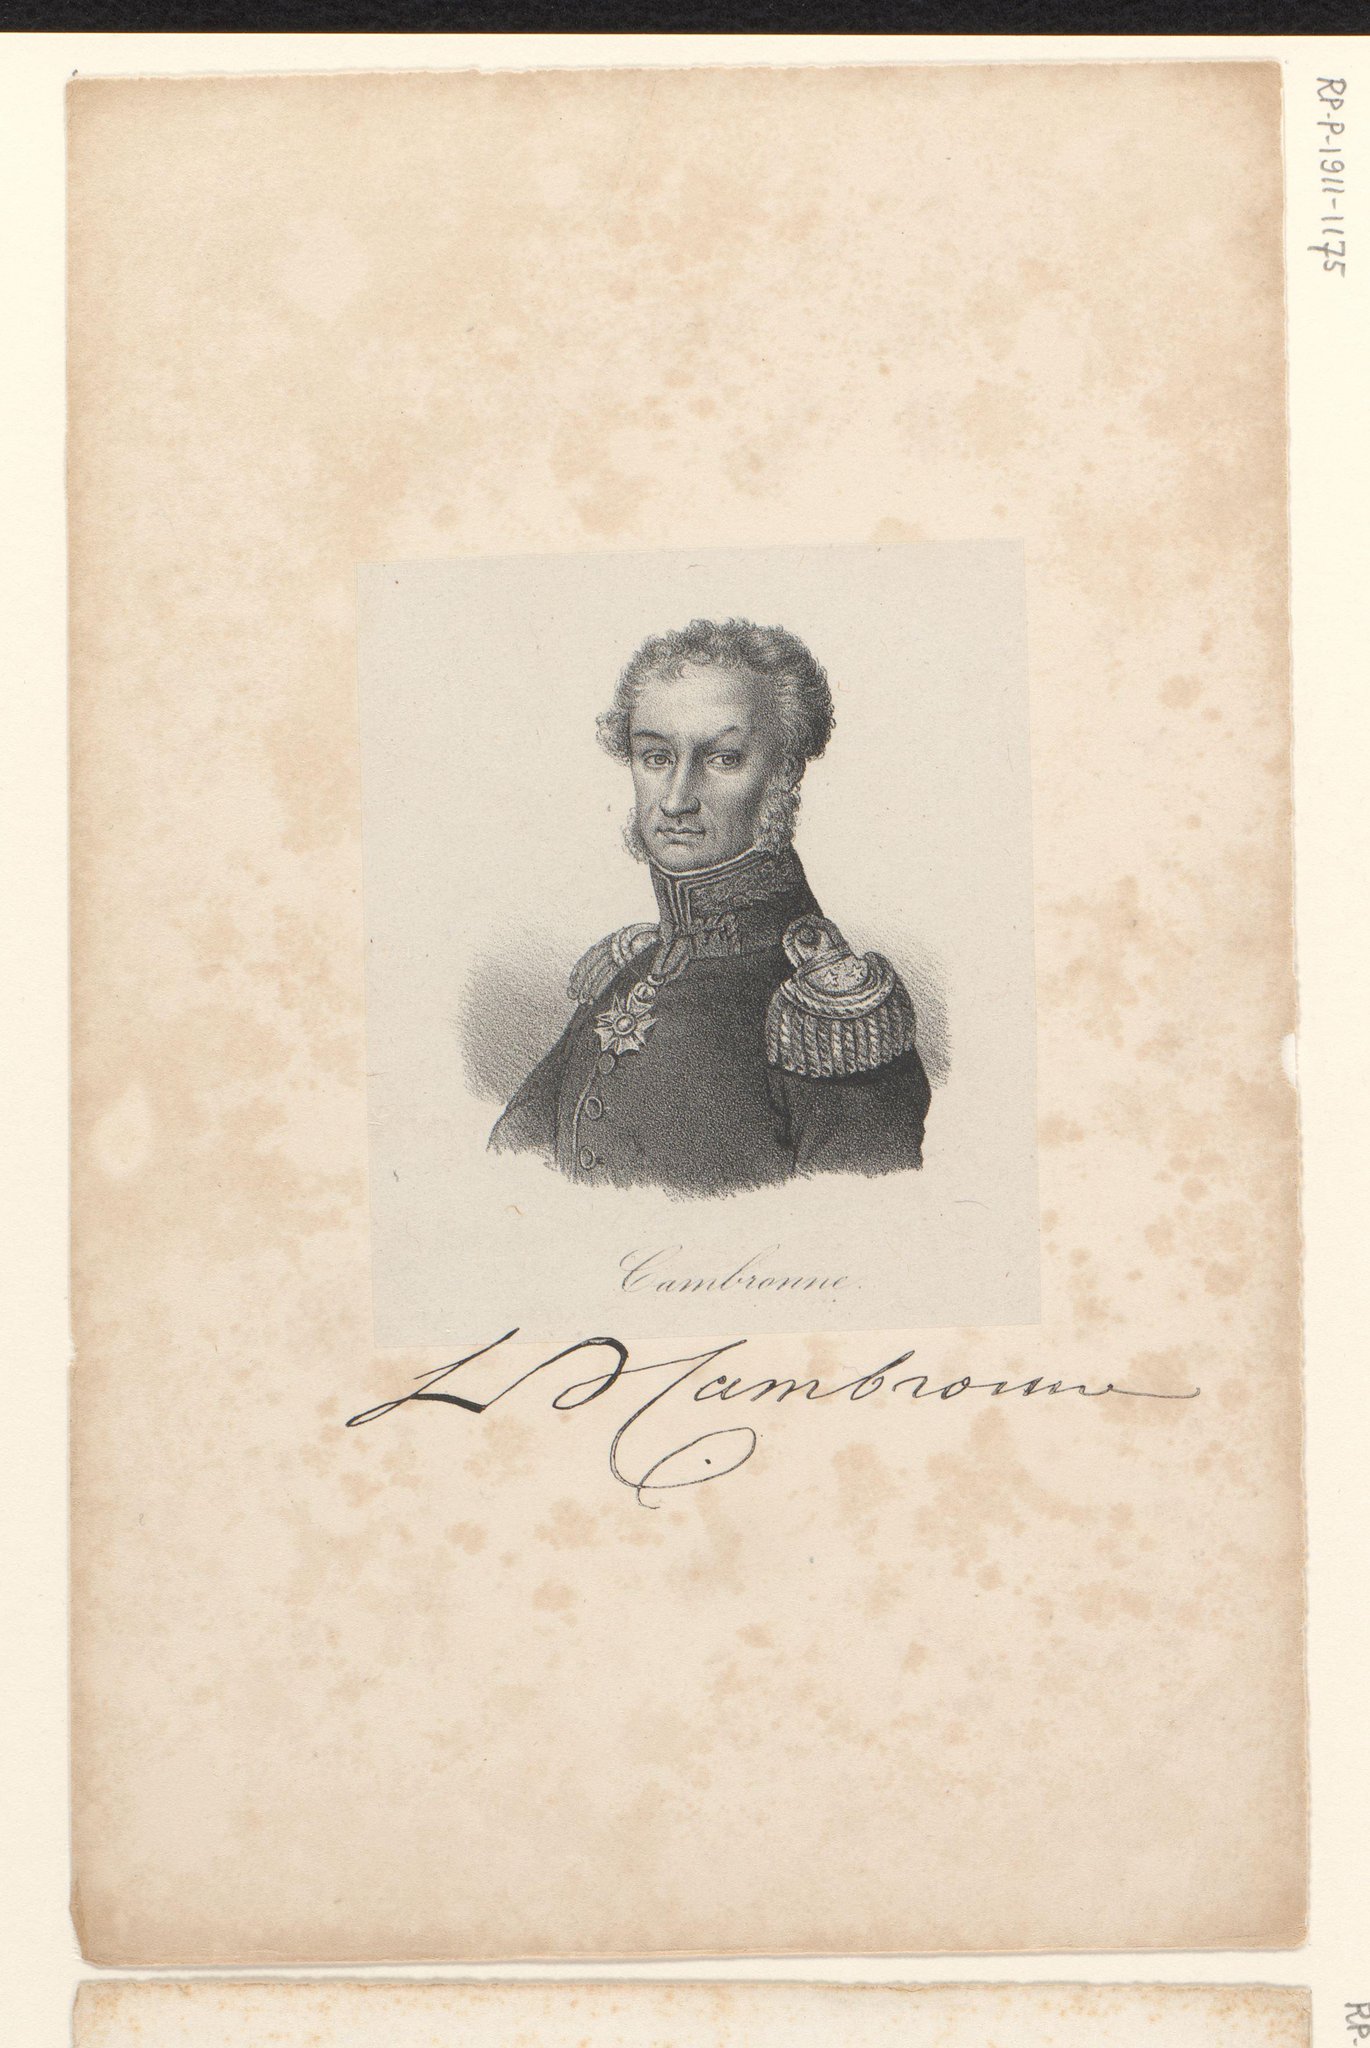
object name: print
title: Cambronne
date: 1818-1842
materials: paper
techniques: lithograph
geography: paris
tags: historical persons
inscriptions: collector's mark: Lugt 2228a